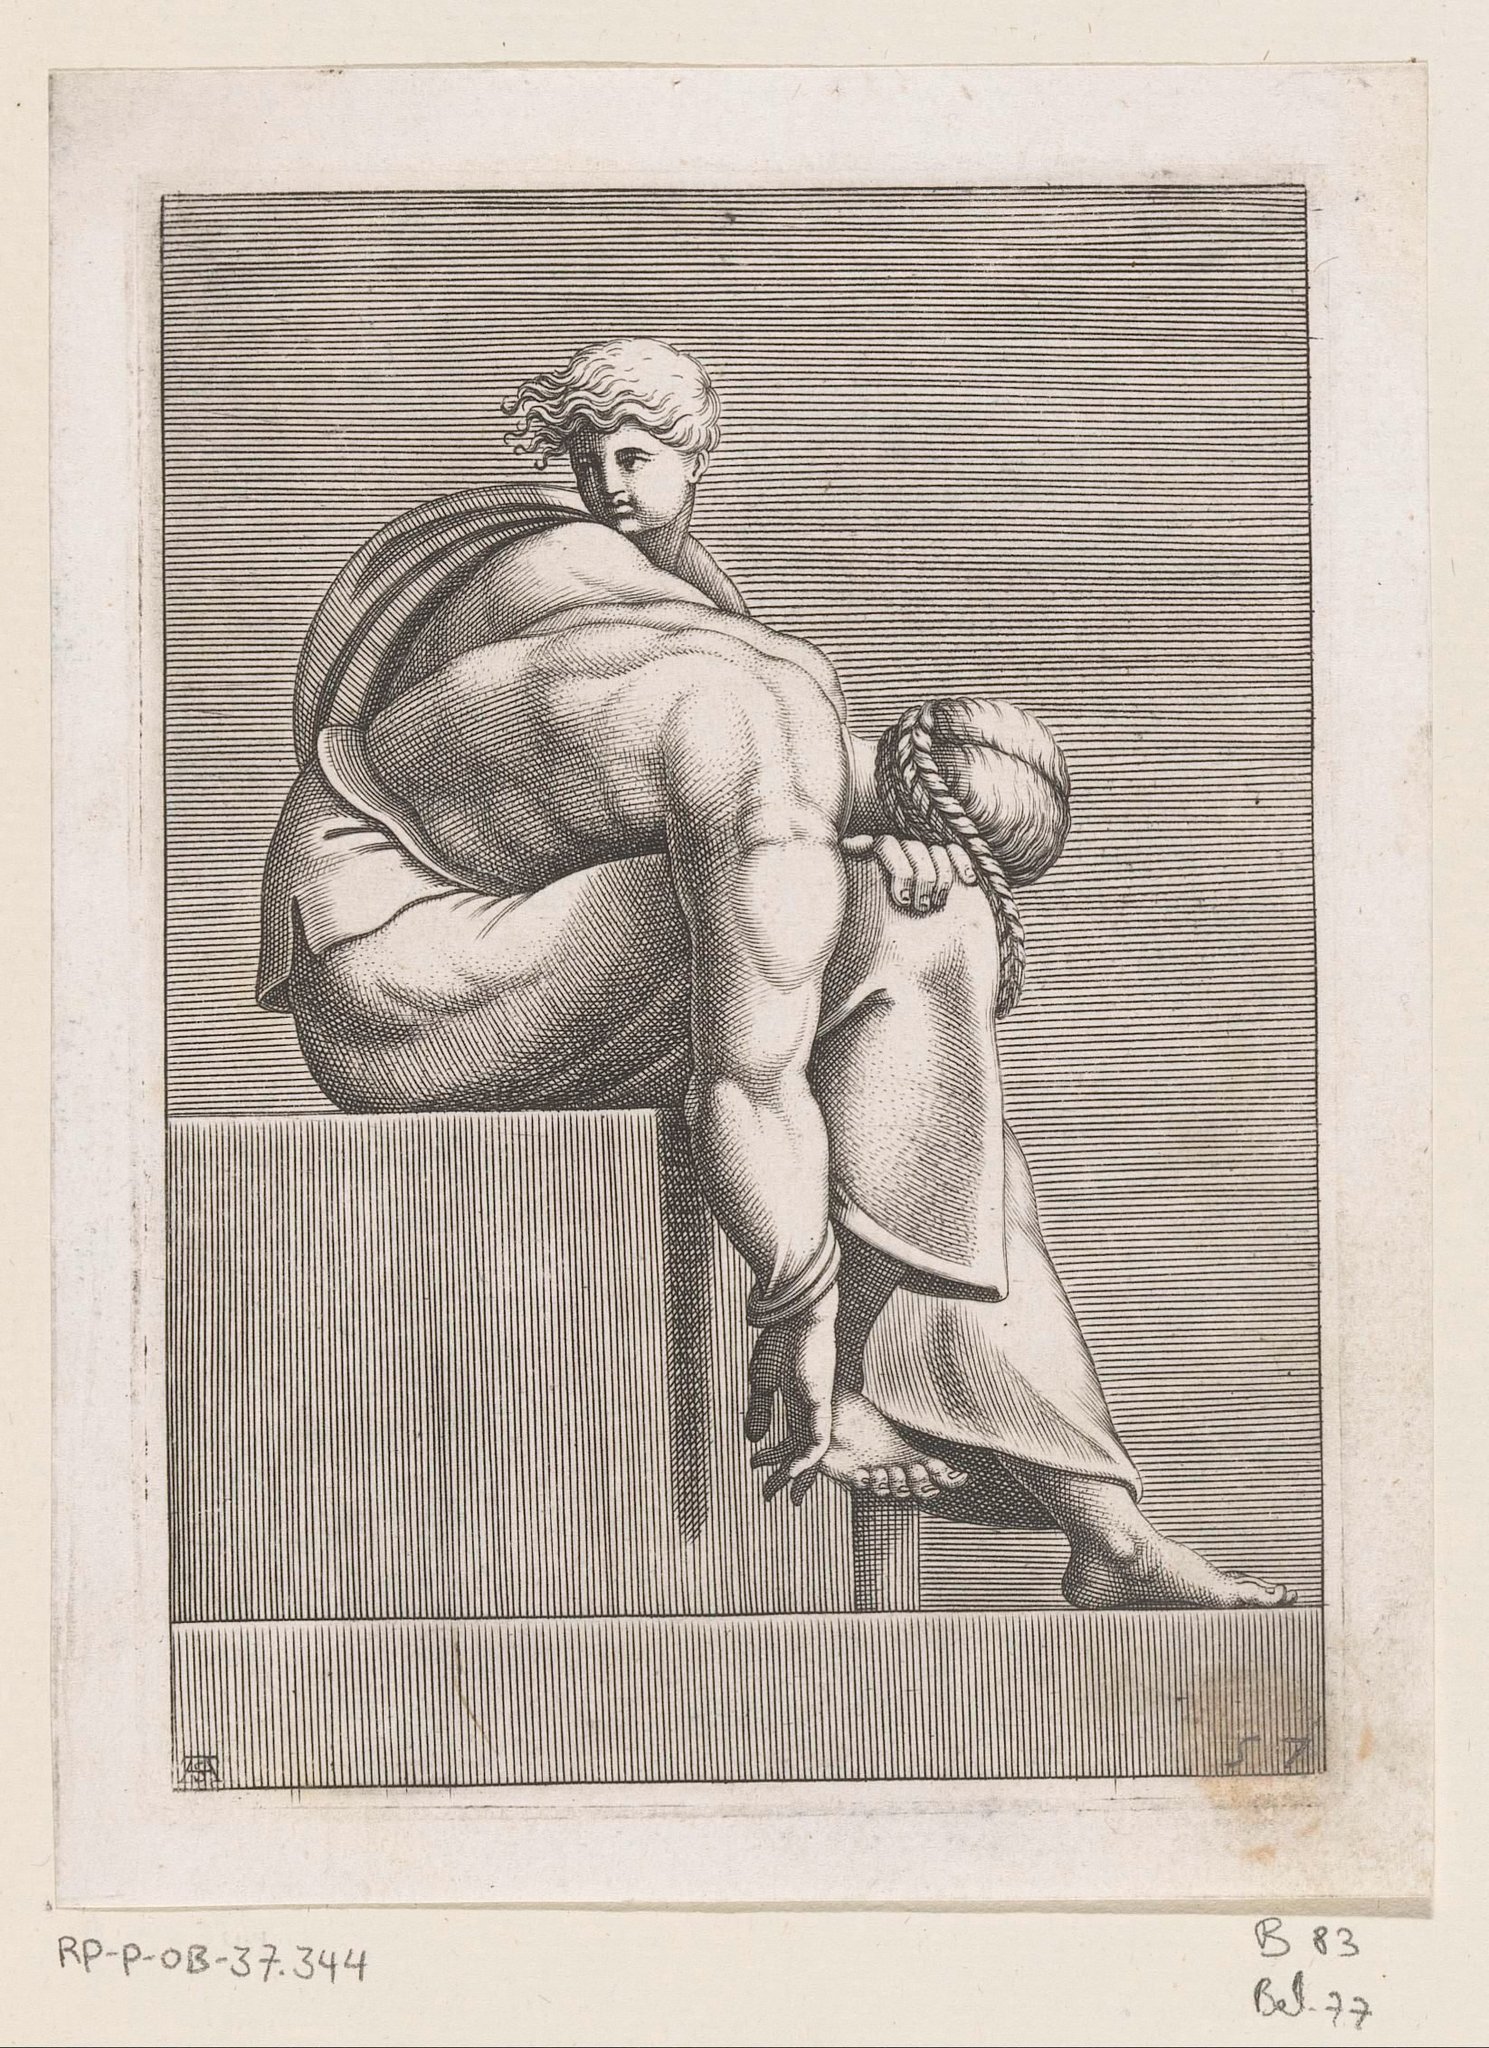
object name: print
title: Voorover leunende vrouw met een kind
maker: adamo scultori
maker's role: painter, print maker, sculptor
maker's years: 1530-1585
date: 1585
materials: paper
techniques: engraving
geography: vatican city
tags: mother and child(ren), woman and child(ren) (family group)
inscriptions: collector's mark: Lugt 240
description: Deze prent maakt deel uit van een serie bestaande uit een titelprent en 72 prenten naar schilderingen door Michelangelo in de Sixtijnse Kapel in het Vaticaan.